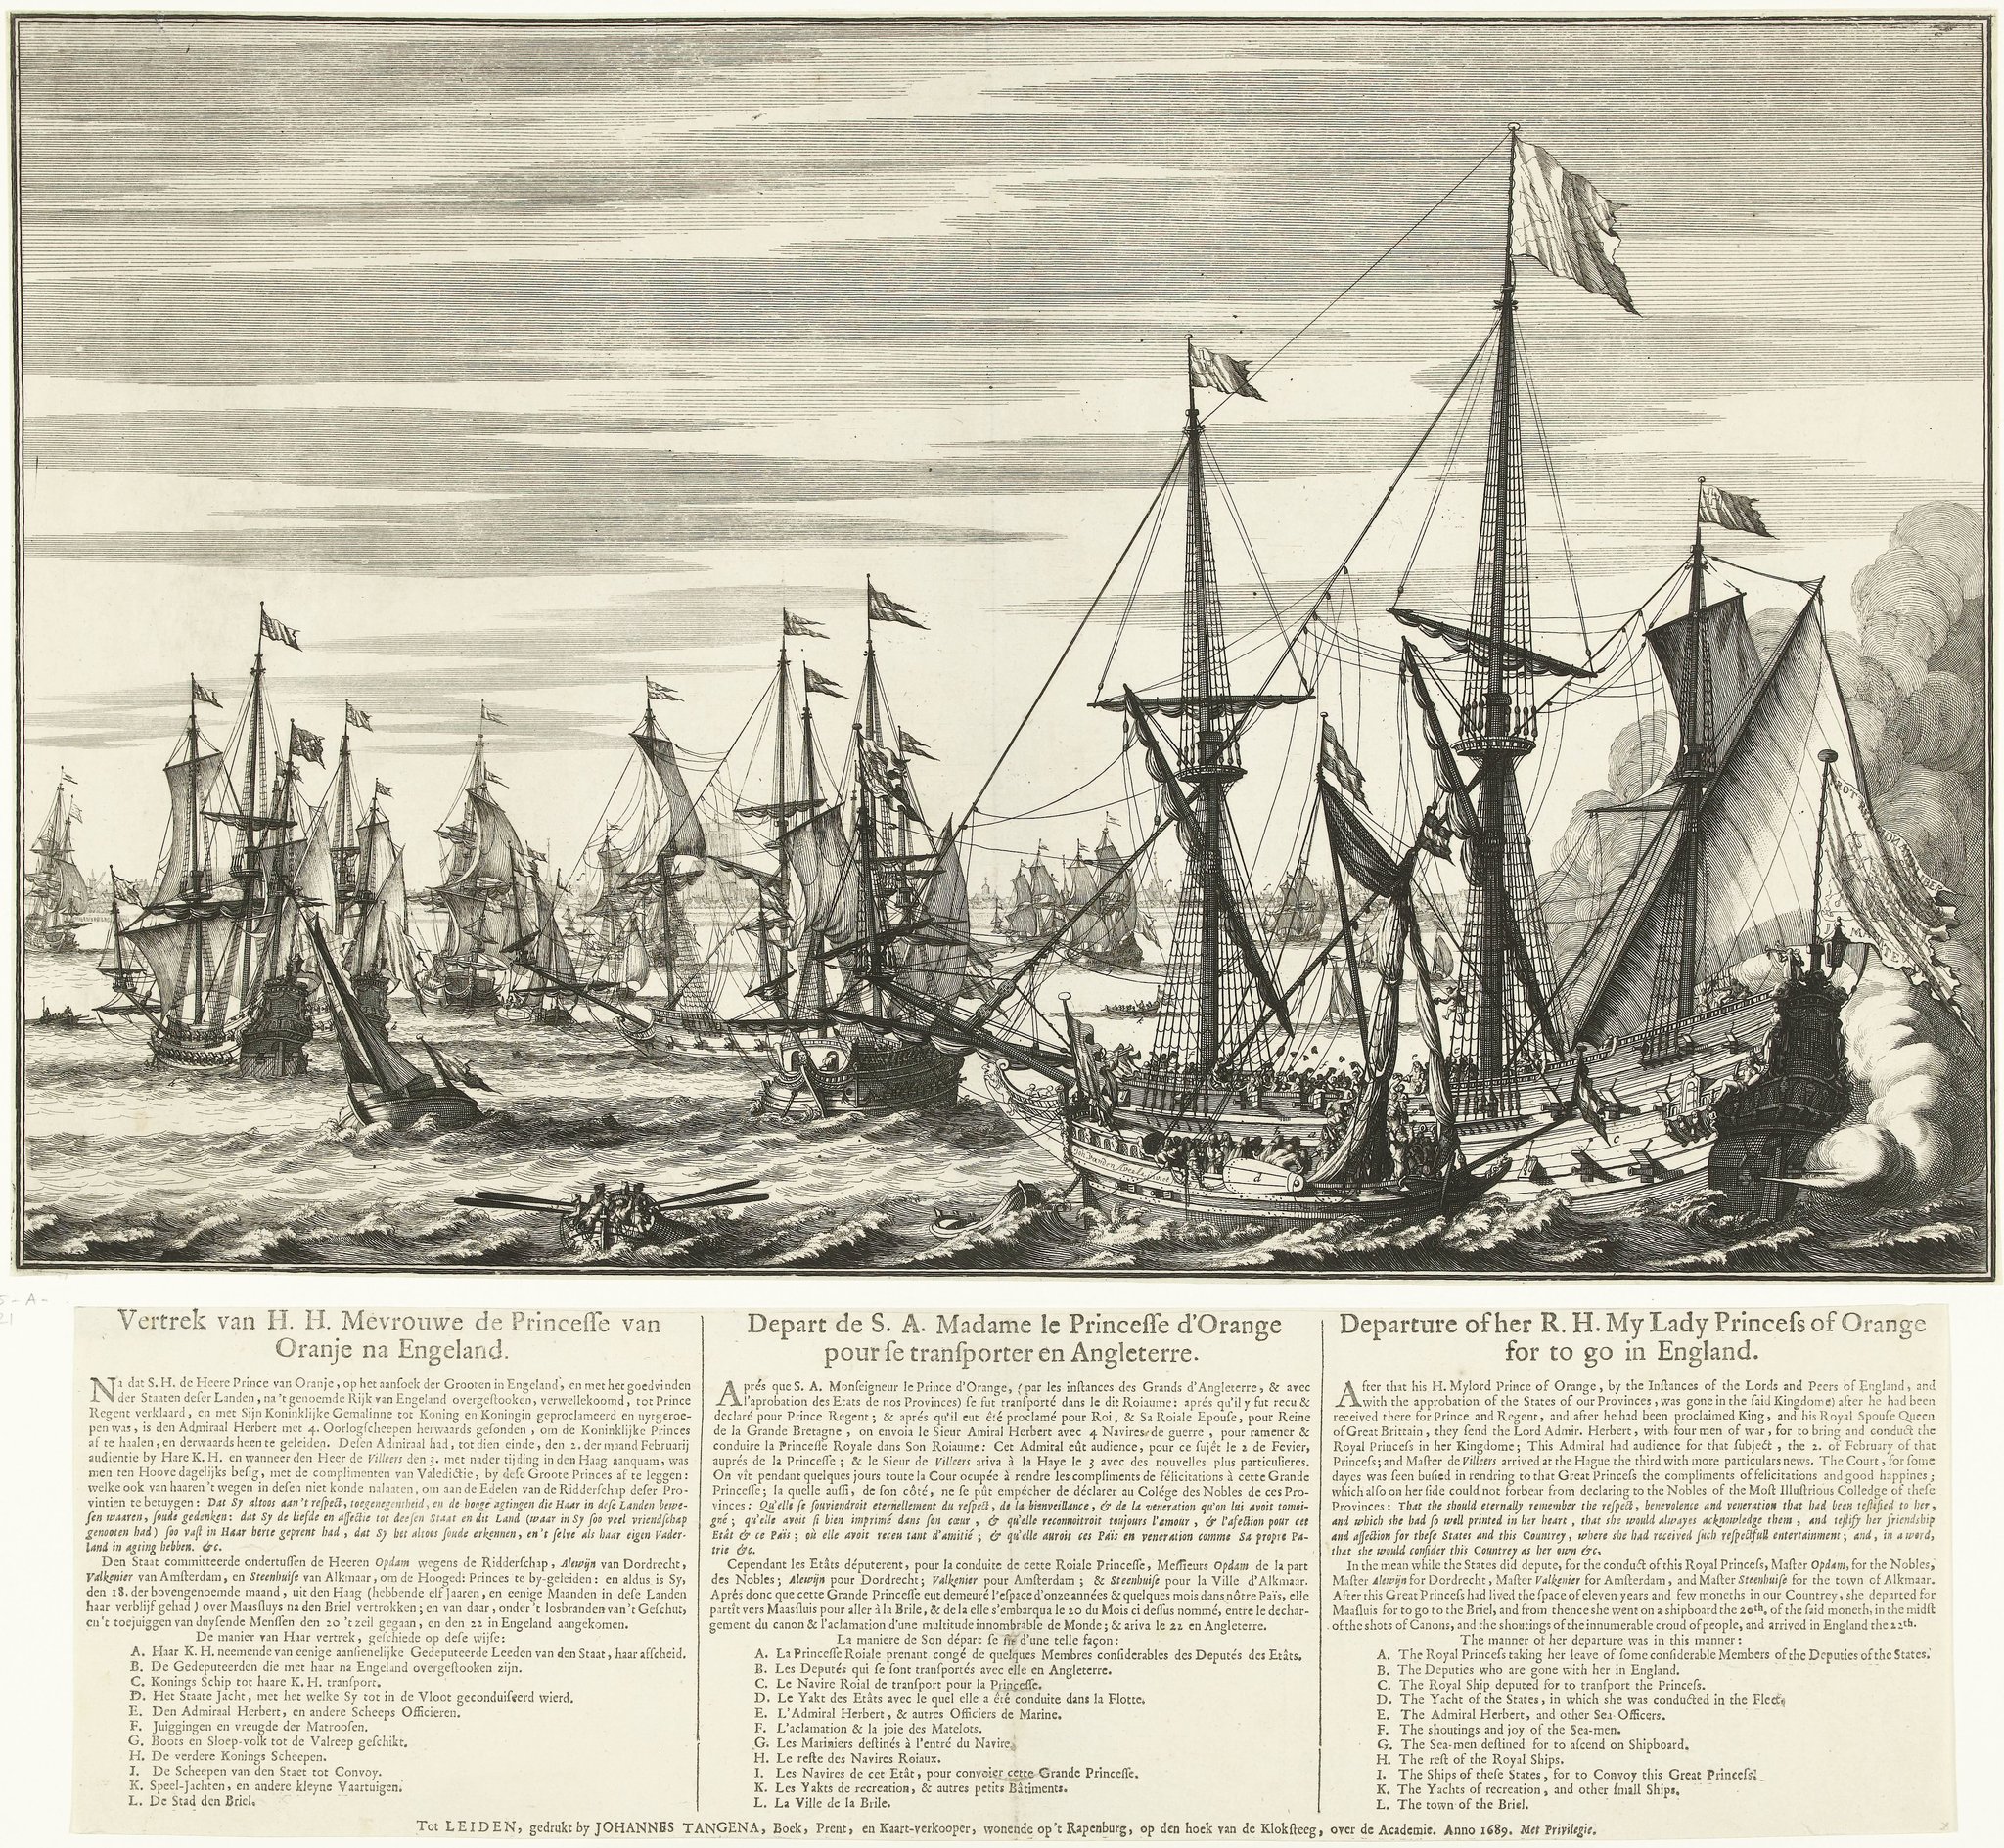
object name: print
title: Vertrek van de prinses van Oranje naar Engeland, 1689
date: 1689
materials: paper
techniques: etching, letterpress printing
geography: netherlands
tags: london, maria ii stuart (koningin van engeland, schotland en ierland), arrival and return ~ travelling, brielle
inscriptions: collector's mark: Lugt 2228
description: Vertrek van prinses Maria Stuart uit Brielle op 20 februari 1689 om zich te voegen bij haar echtgenoot in Londen. De prinses stapt over van het Statenjacht naar het schip dat haar naar Engeland zal brengen. Onder de plaat drie teksten met de legenda's A-L in het Nederlands, Frans en Engels.